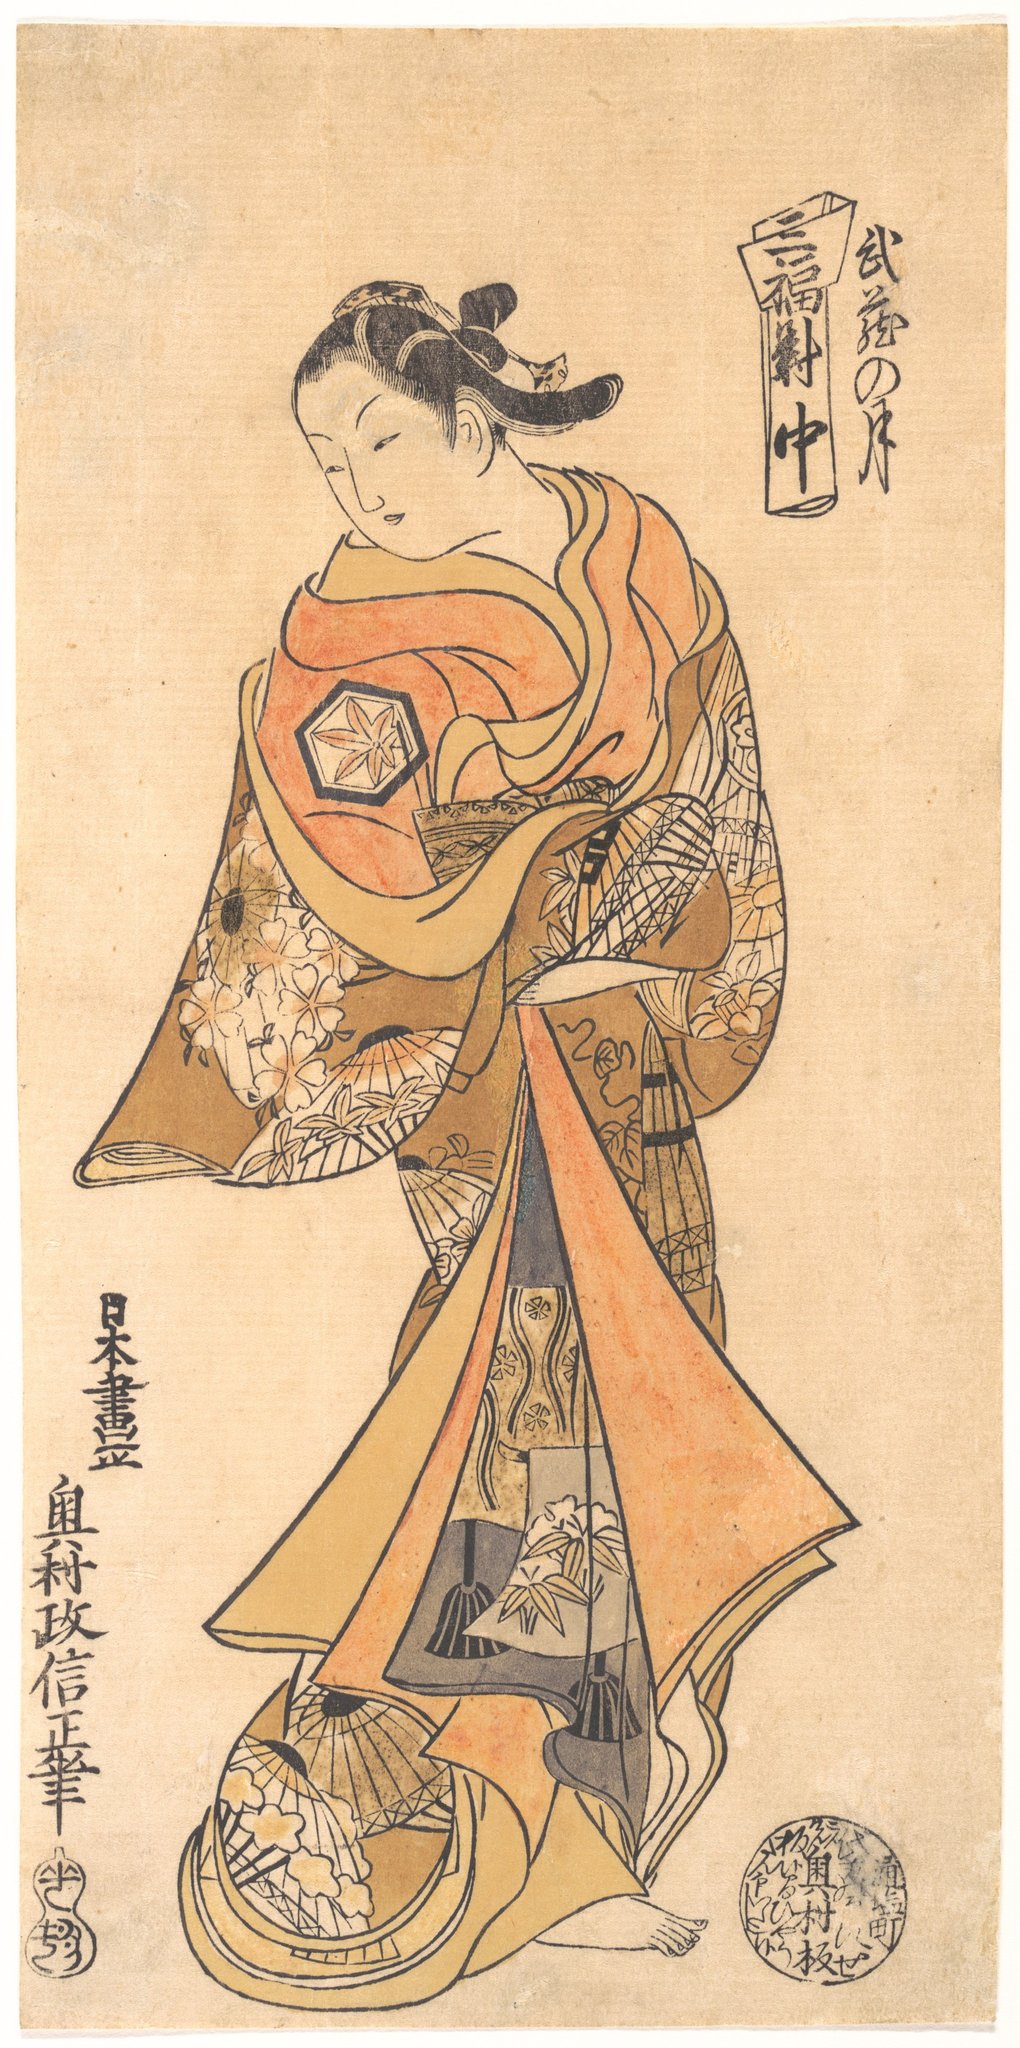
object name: print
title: Moon in Musashi Province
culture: japanese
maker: okumura masanobu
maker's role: artist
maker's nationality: japanese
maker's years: 1686-1764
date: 1740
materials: ink, paper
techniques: woodblock print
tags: women